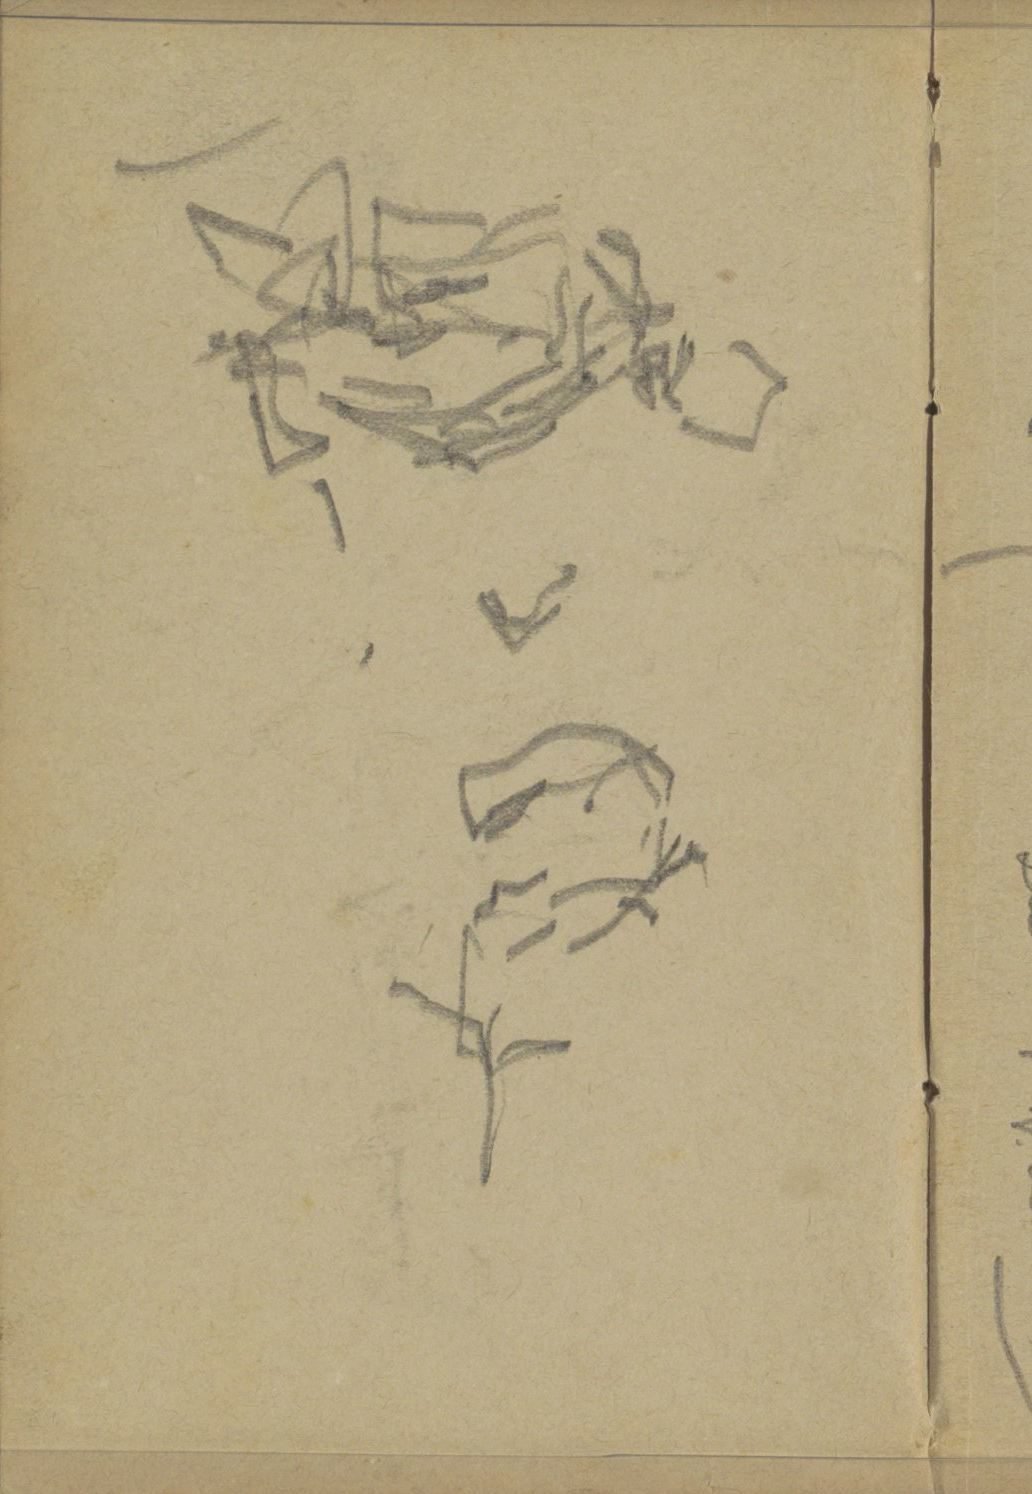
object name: sketchbook leaf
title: Figuurstudies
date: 1887-1891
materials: paper, pencil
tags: adult man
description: Pagina 71 uit een schetsboek met 83 bladen.